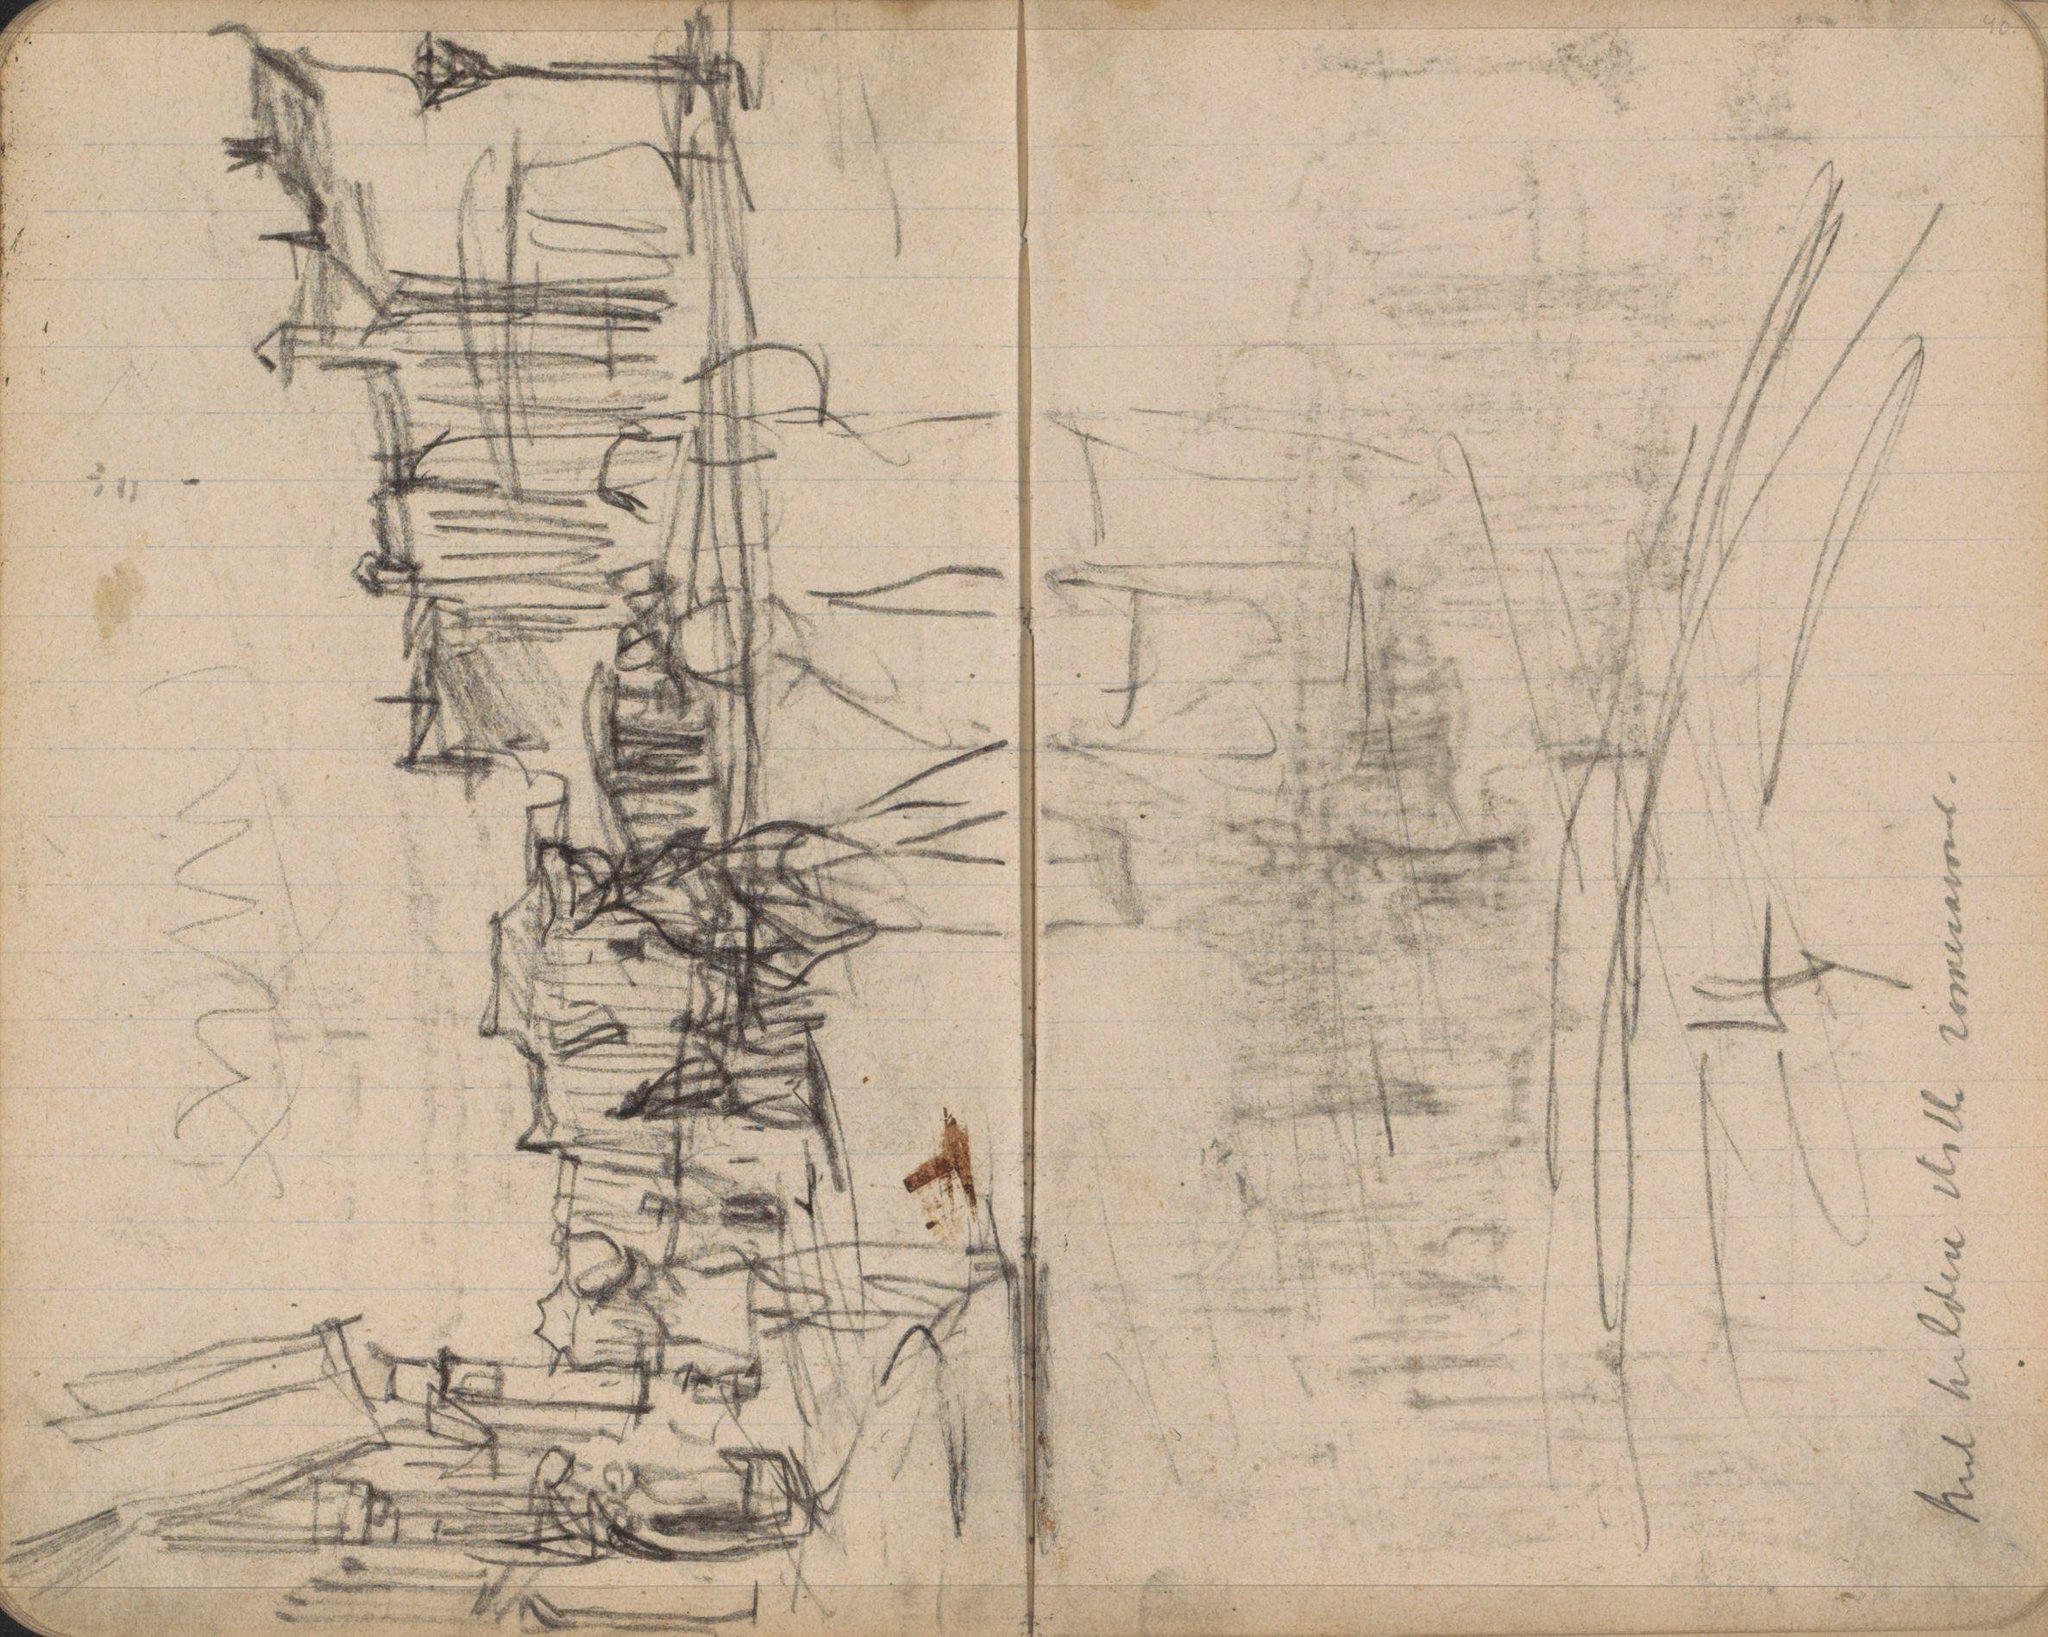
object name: sketchbook leaf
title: Gezicht op het Rokin te Amsterdam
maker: george hendrik breitner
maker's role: draughtsman, painter, print maker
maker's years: 1857-1923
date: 1903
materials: chalk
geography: amsterdam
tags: bridge in city across river, canal, etc. (+ city(-scape) with figures, staffage), civic architecture; edifices; dwellings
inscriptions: annotation: ‘heel heldere [...] zomeravond.’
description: Mogelijk gezien vanuit Rokin 112, kunstenaarsvereniging Arti et Amicitiae. Vooraan mogelijk de Langebrug. Pagina 39 en pagina 40 uit een schetsboek met 32 bladen.